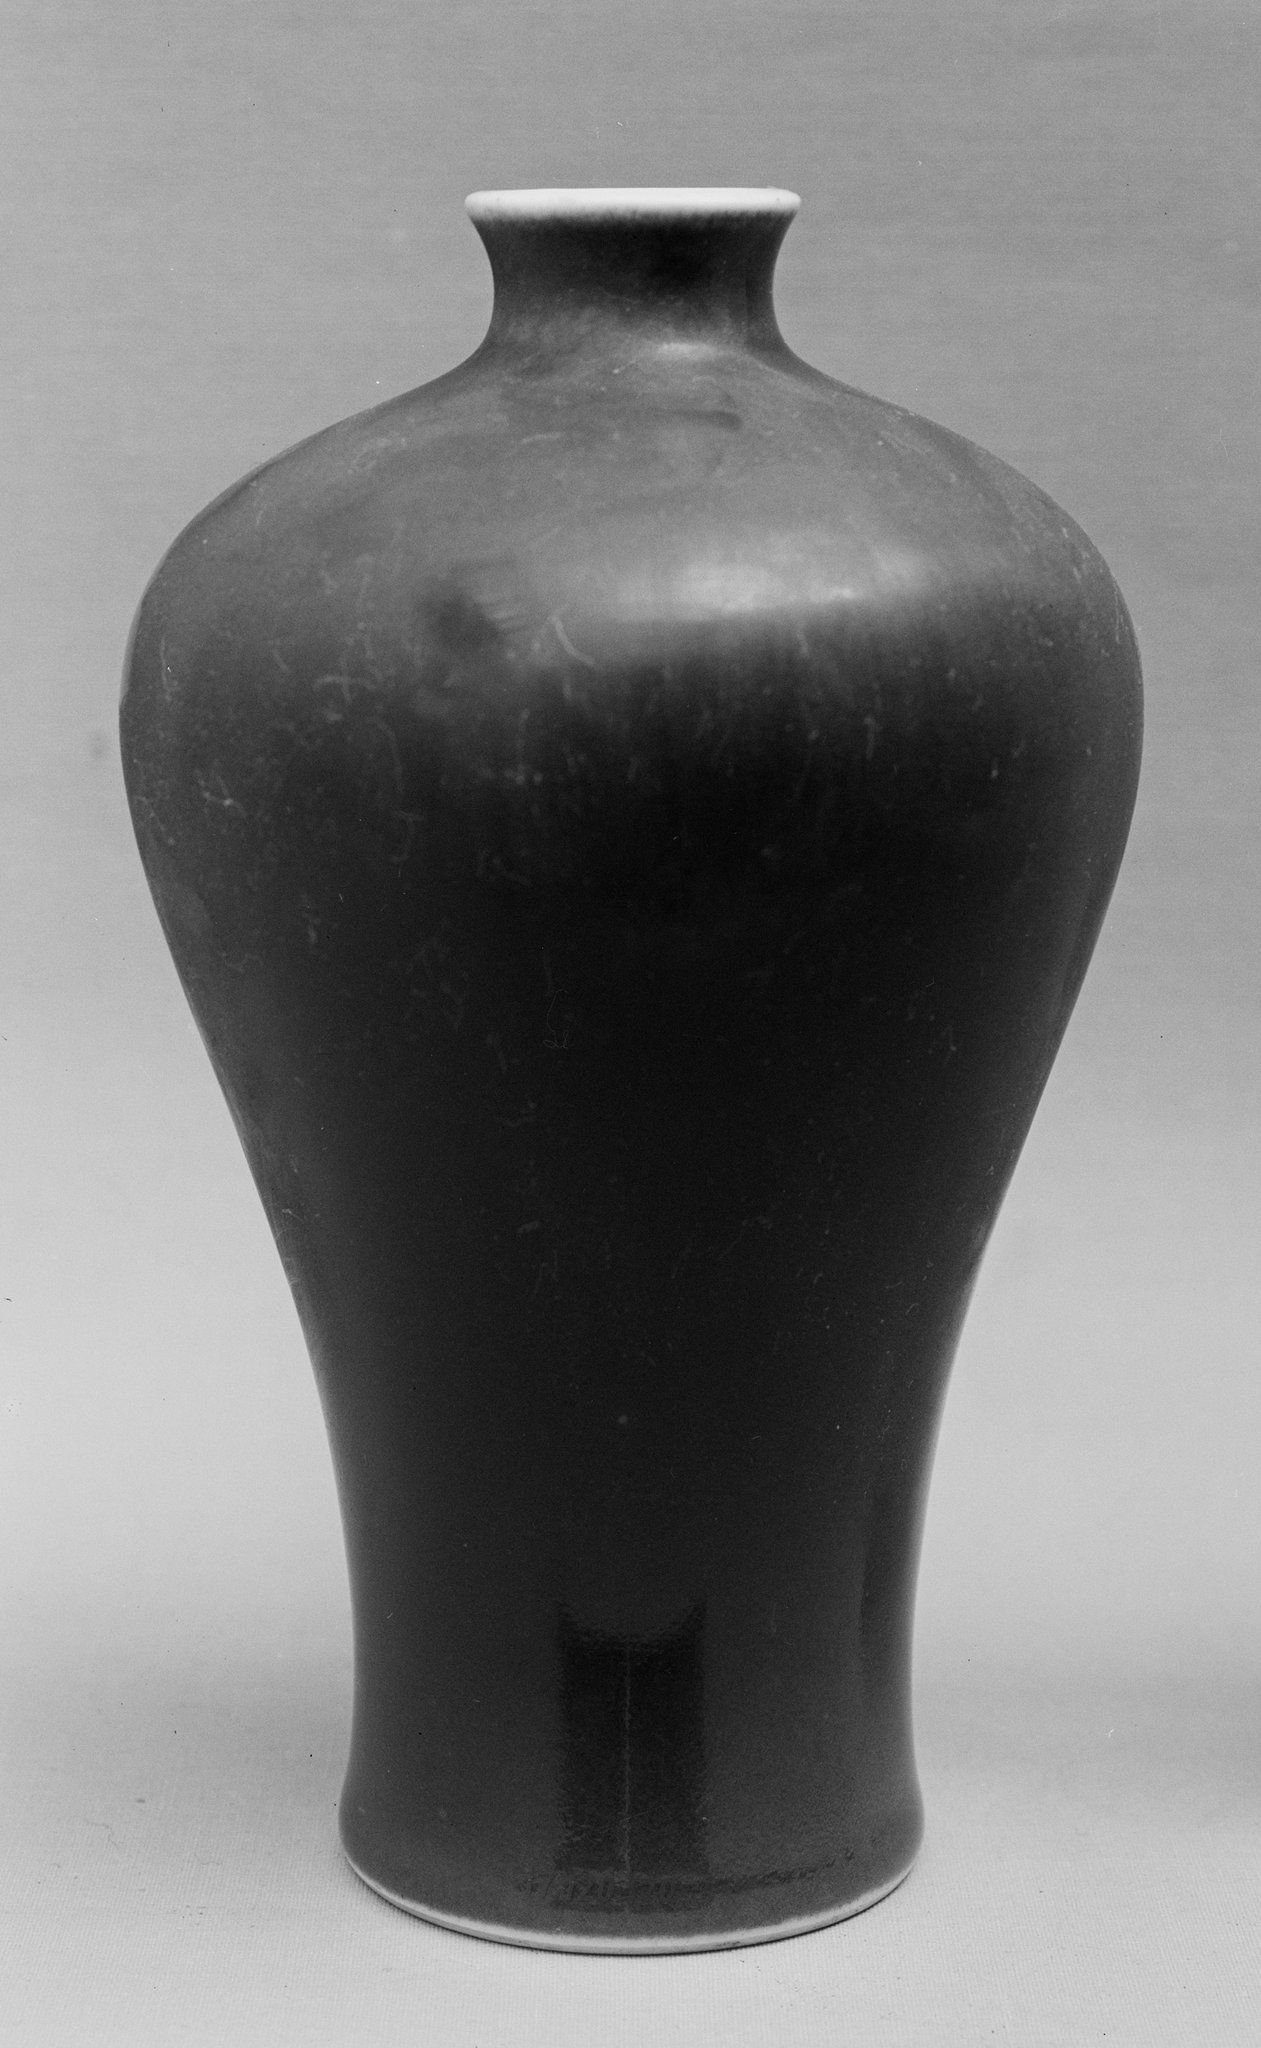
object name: vase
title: Meiping vase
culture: chinese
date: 1767-1800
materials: copper, glaze, porcelain